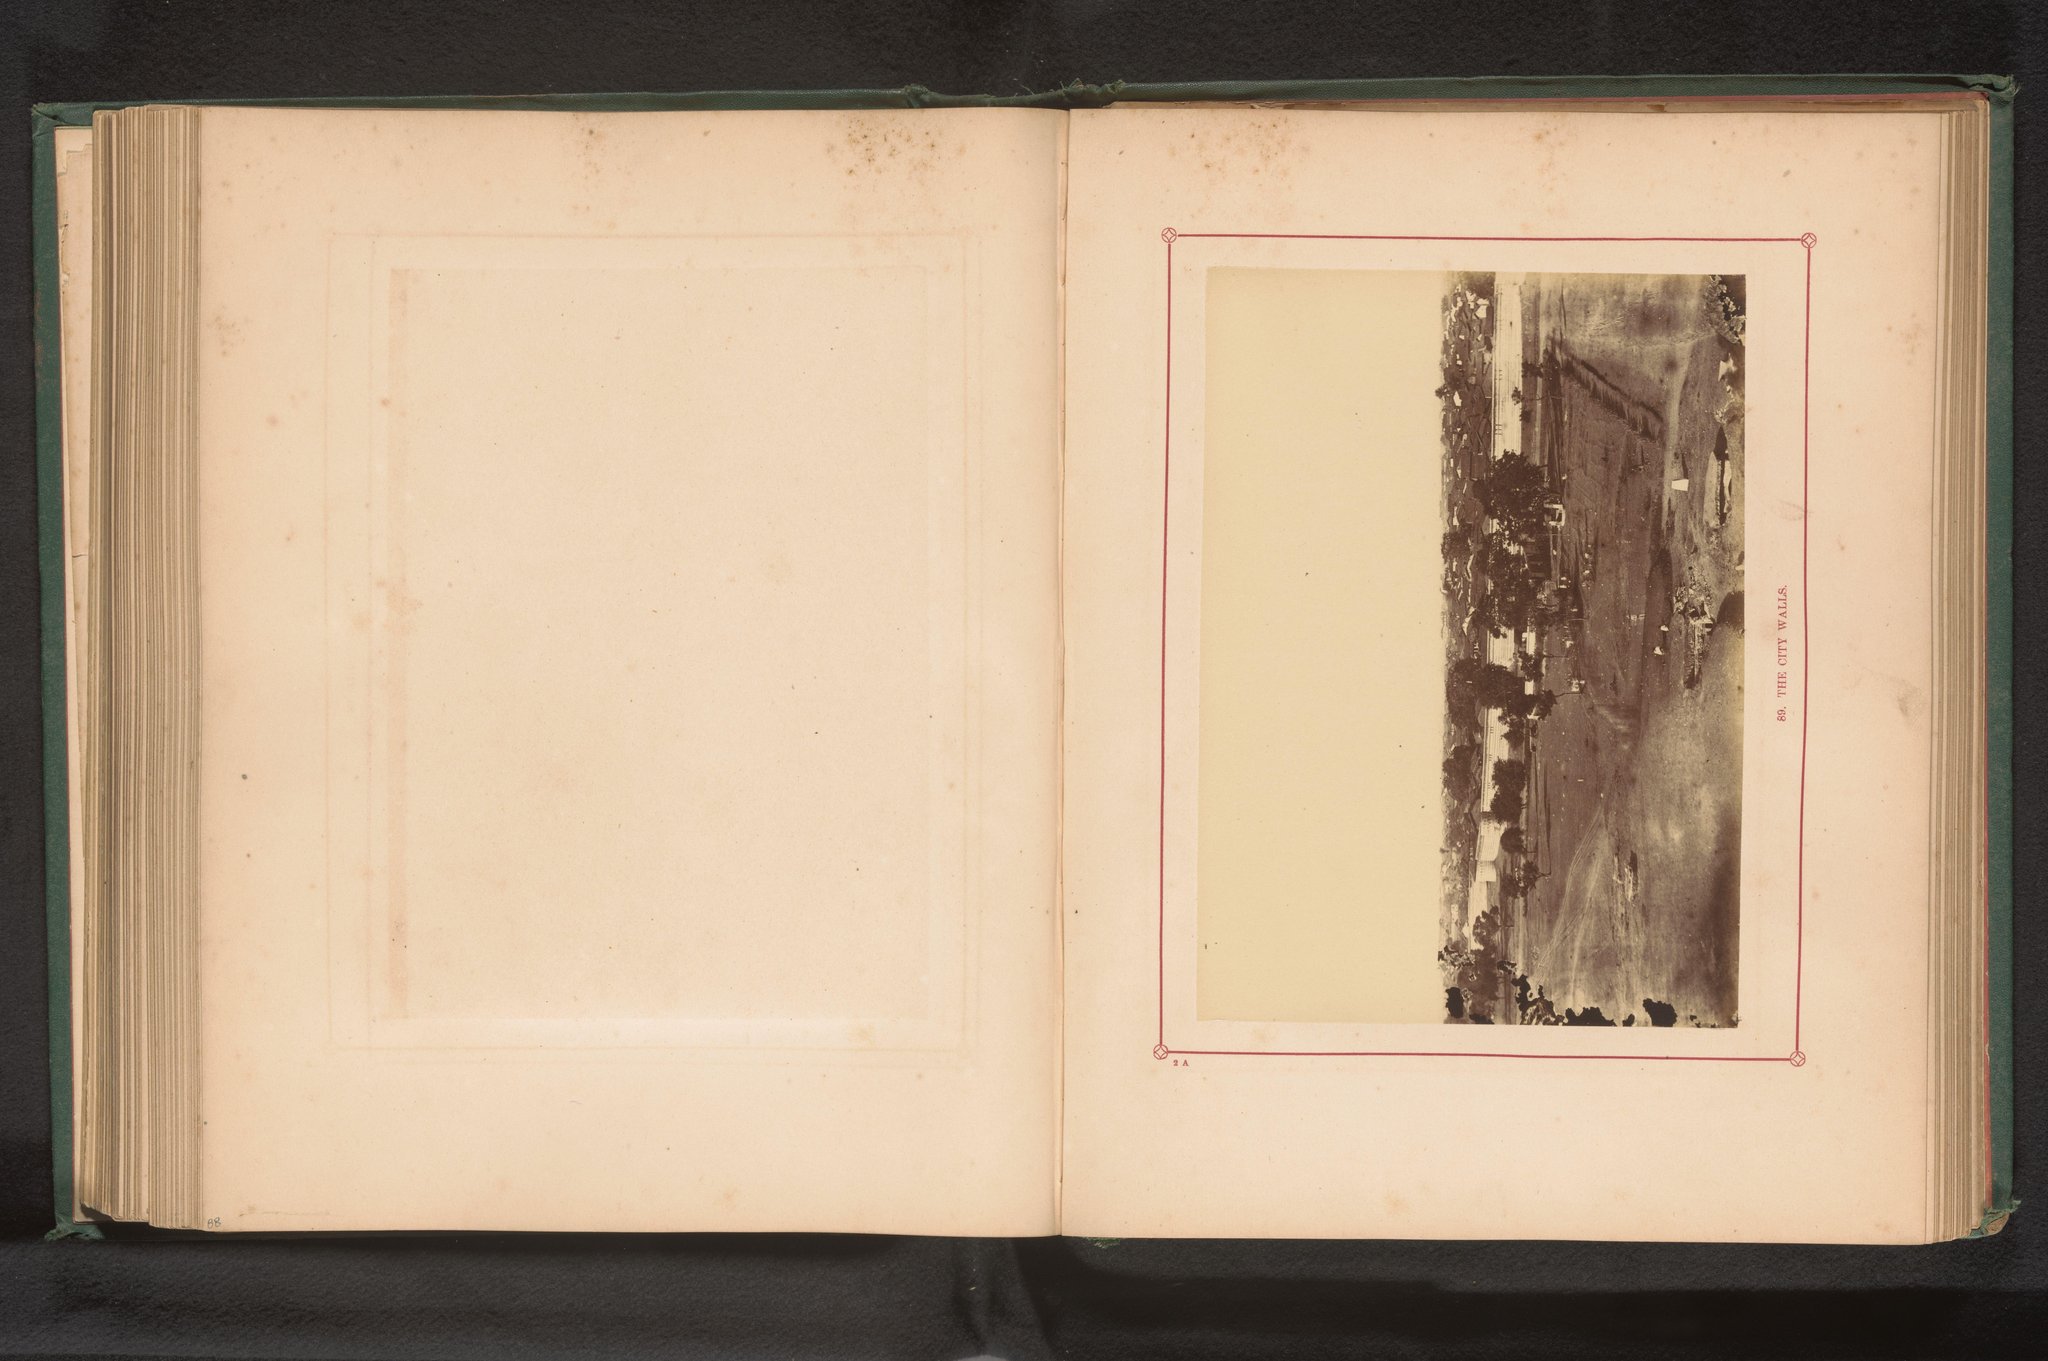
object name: page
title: Gezicht op de stadsmuren van Ahmedabad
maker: thomas biggs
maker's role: fotograaf, kapitein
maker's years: 1822-1905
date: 1856-1866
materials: photographic support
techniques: albumen print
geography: ahmedabad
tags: city-walls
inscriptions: inscription: ‘2A’, number: ‘89.’